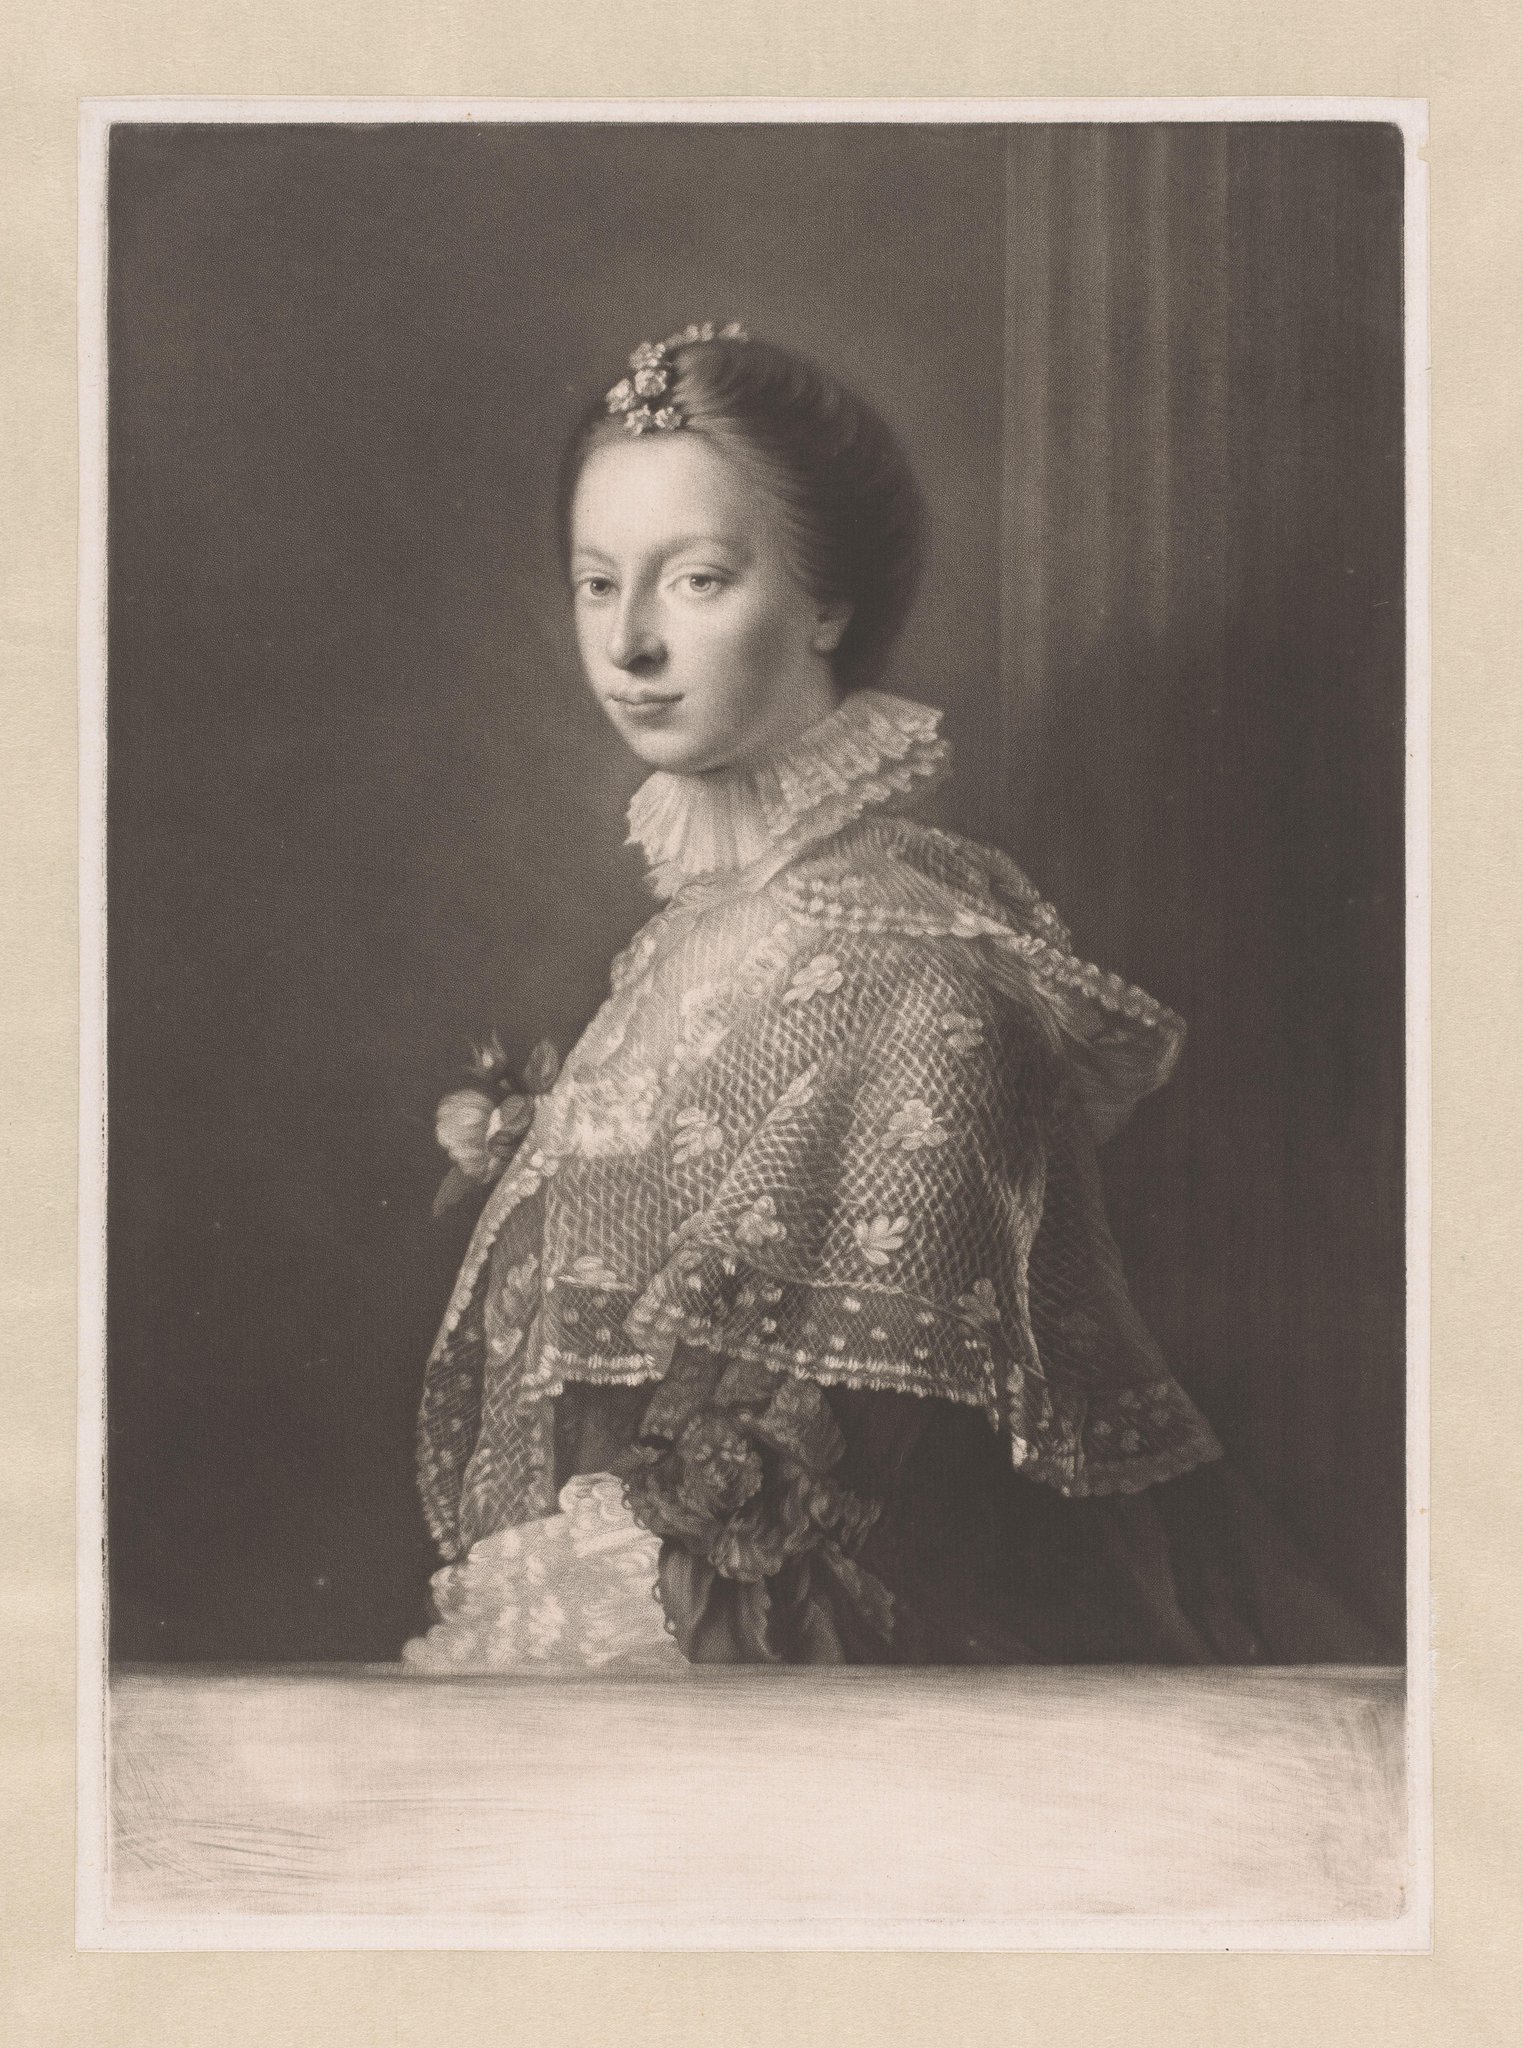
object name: print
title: Portret van Janet Erskine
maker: james watson (prentmaker)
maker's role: print maker, publisher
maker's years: 1740-1790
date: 1761-1790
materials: paper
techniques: mezzotint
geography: london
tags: historical persons - bb - woman, lace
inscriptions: collector's mark: Lugt 240